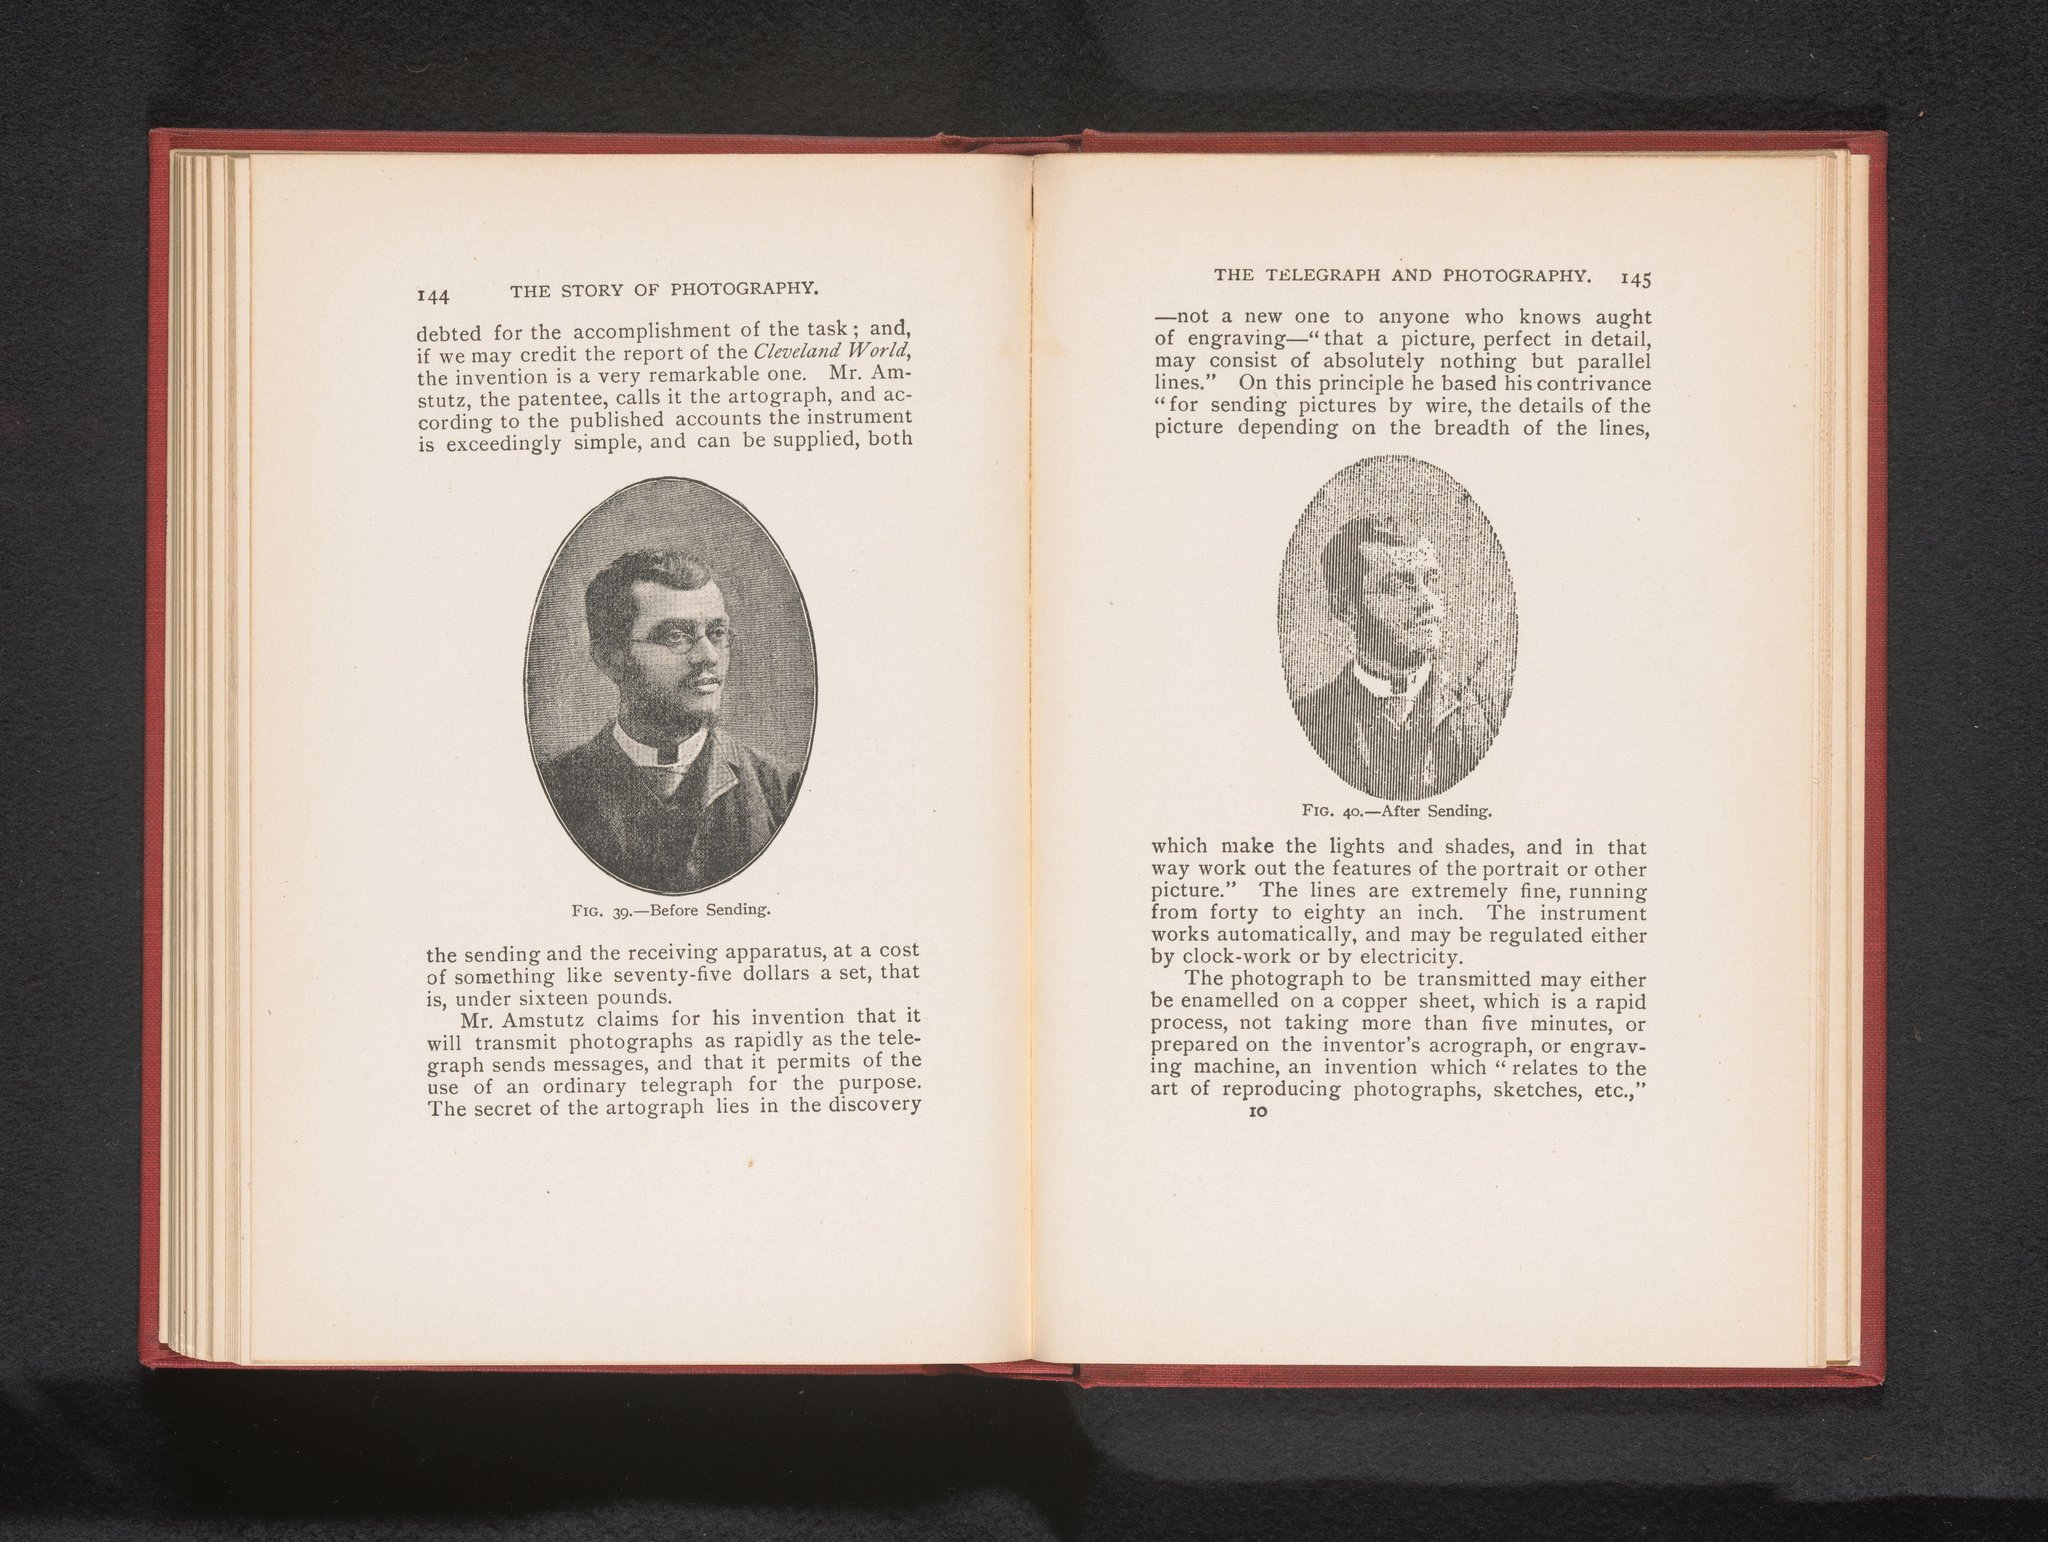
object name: page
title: Portret van een onbekende man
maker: Anonymous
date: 1894-1904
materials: paper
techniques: autotype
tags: adult man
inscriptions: number: ‘Fig. 39.’